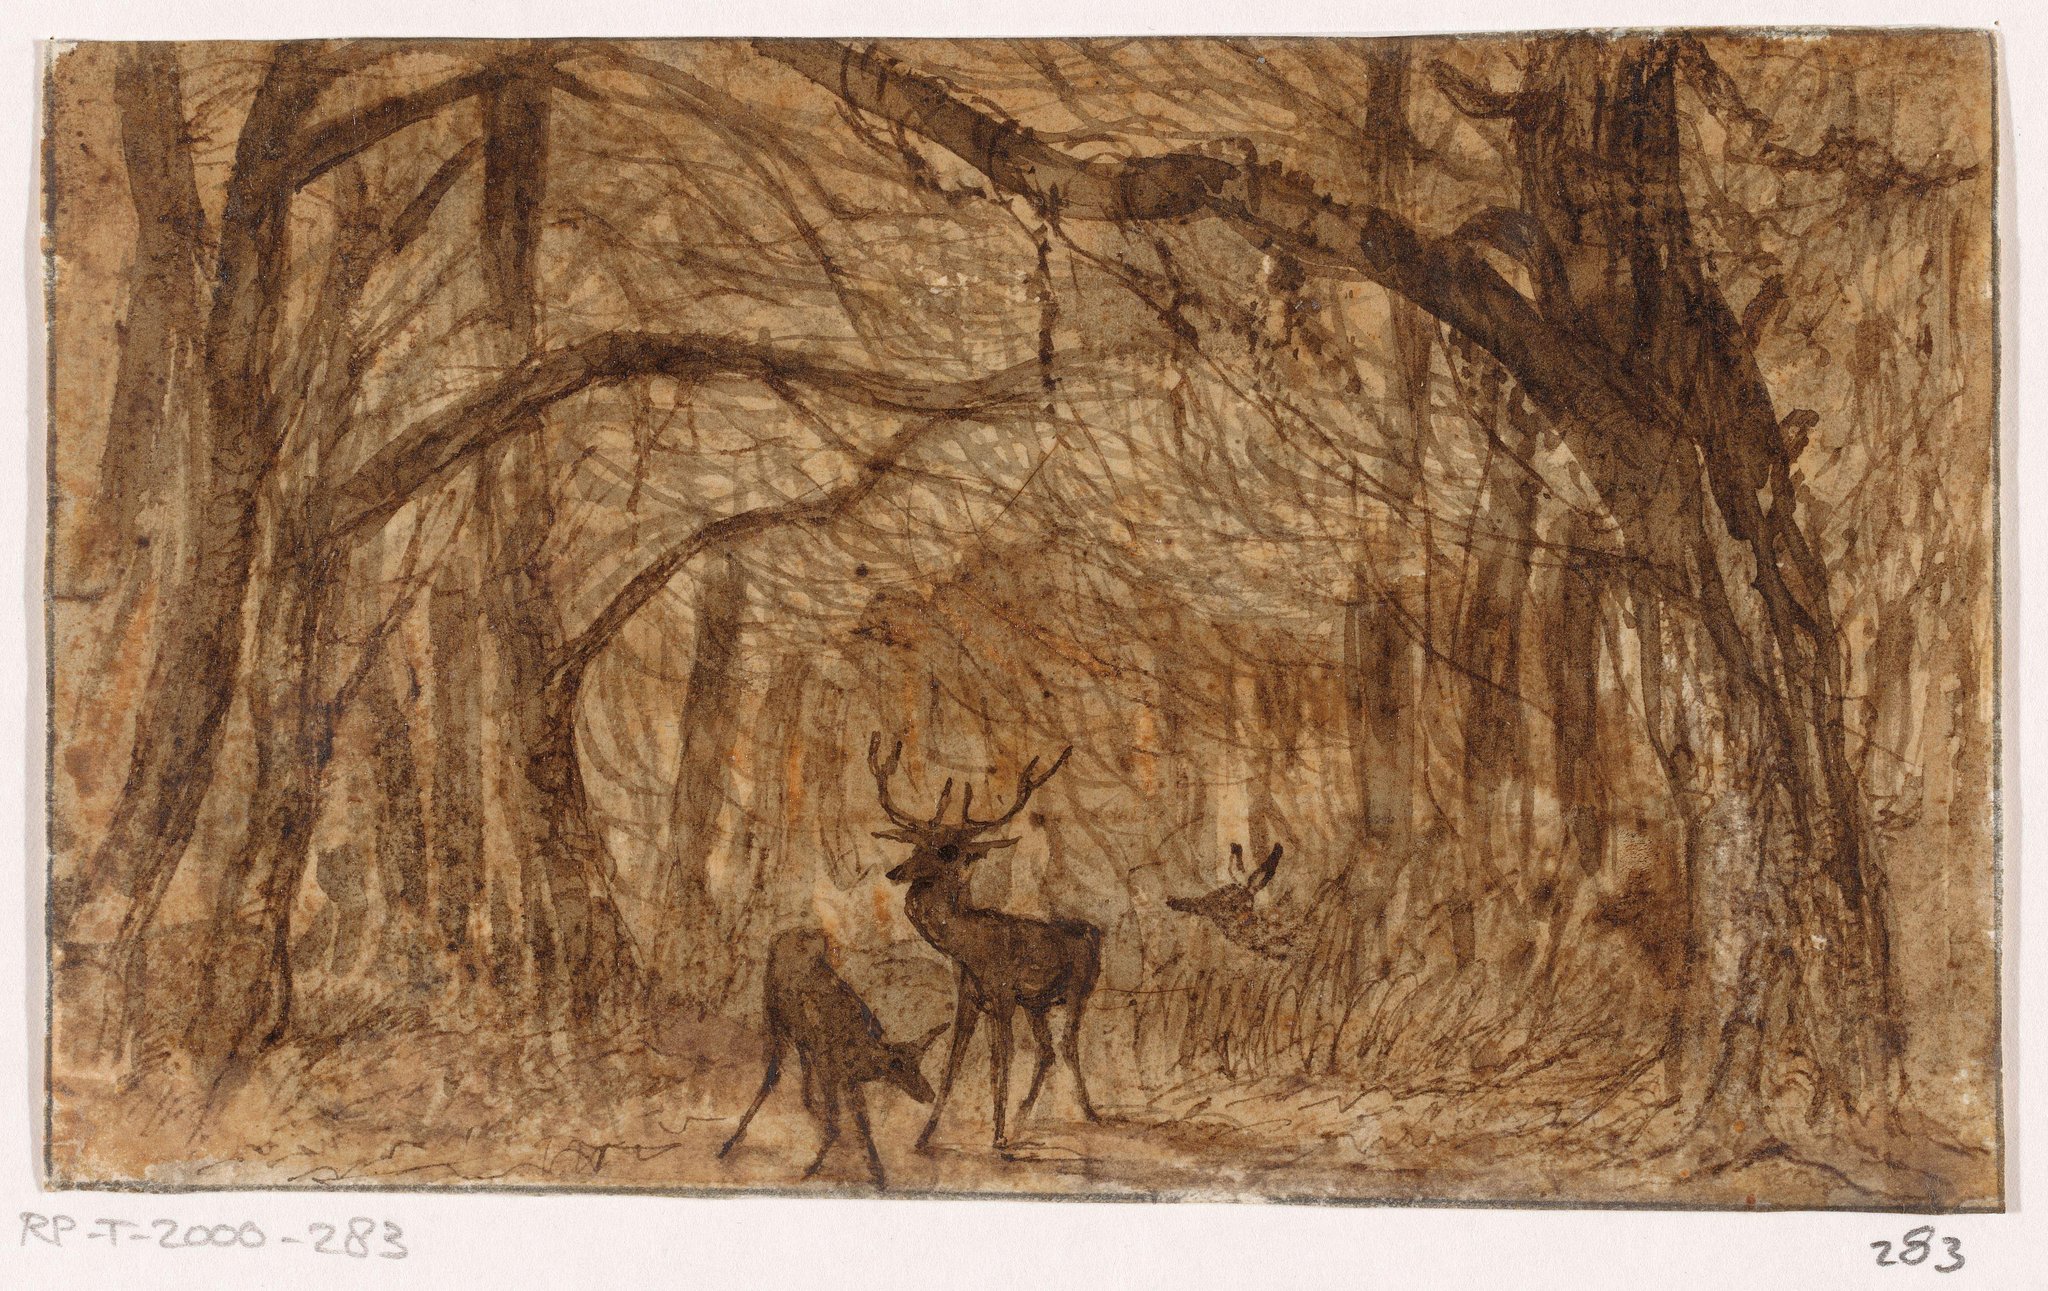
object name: drawing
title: Boslandschap met herten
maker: johannes tavenraat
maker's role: draughtsman, painter, print maker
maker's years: 1809-1881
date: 1840-1880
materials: ink, lacquer, paper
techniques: brush, lacquer, pen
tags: hoofed animals: deer, forest, wood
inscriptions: signature: ‘Tavenraat’, collector's mark: Lugt 2228